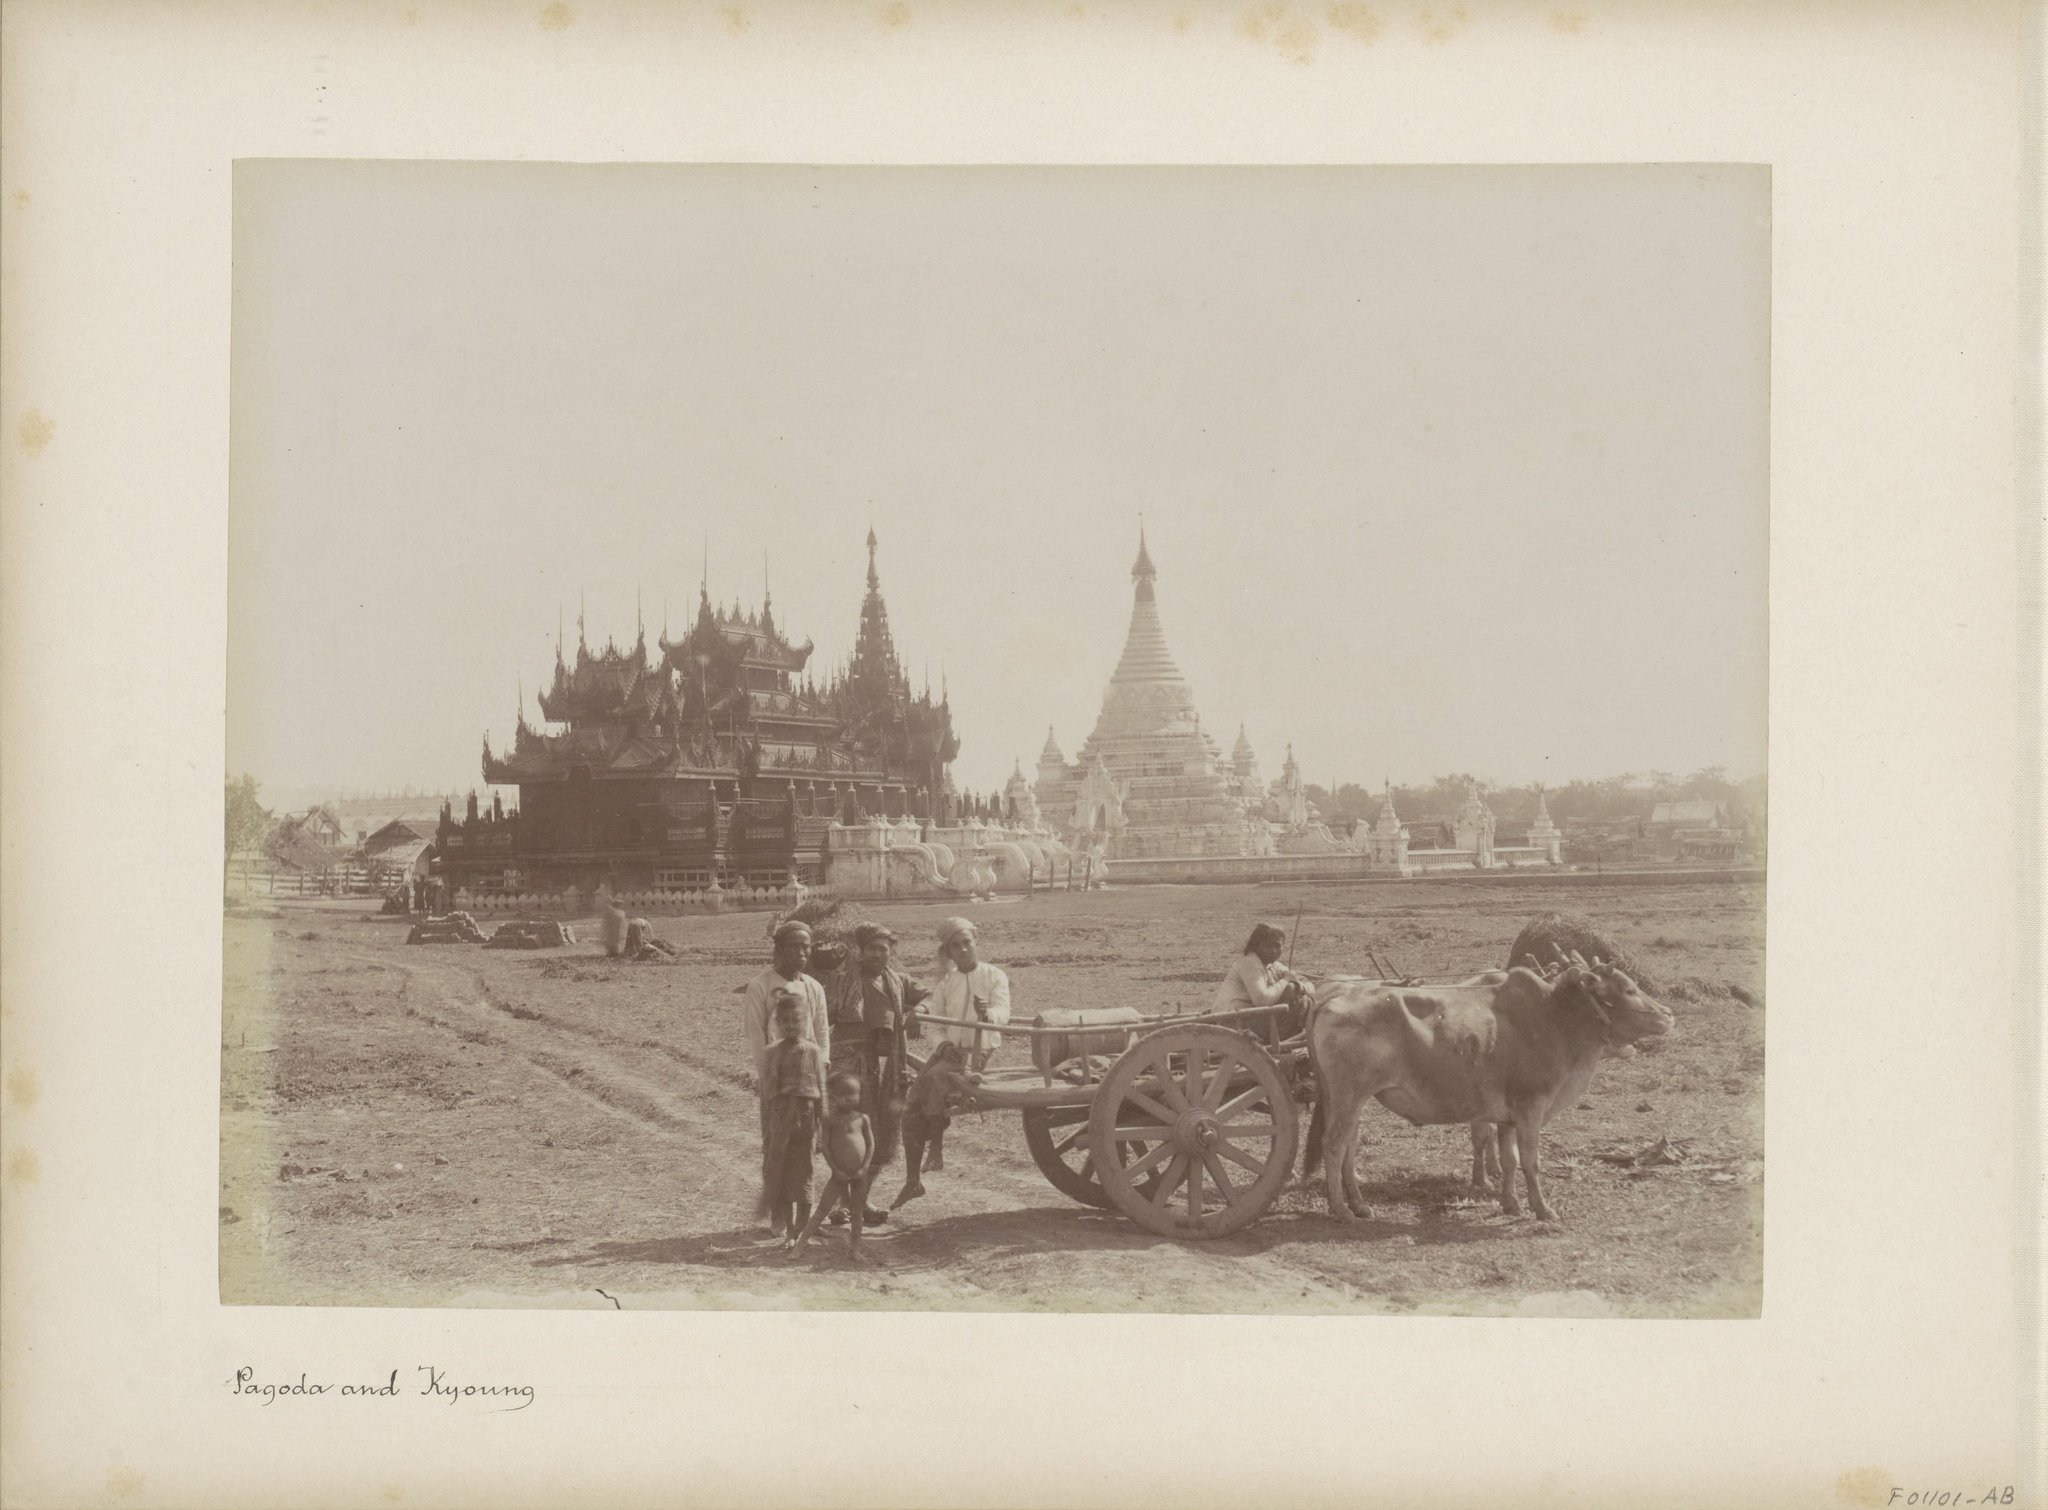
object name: album leaf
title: Bullock cart with Burmese people in front of a pagoda and a monastery, Myanmar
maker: Anonymous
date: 1885-1886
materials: cardboard, paper, photographic support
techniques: albumen print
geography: myanmar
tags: temple, shrine ~ hinduism, buddhism, jainism, two-wheeled, animal-drawn vehicle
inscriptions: caption: ‘Pagoda and Kyoung’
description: Onderdeel van Reisalbum met foto's van bezienswaardigheden in Birma.